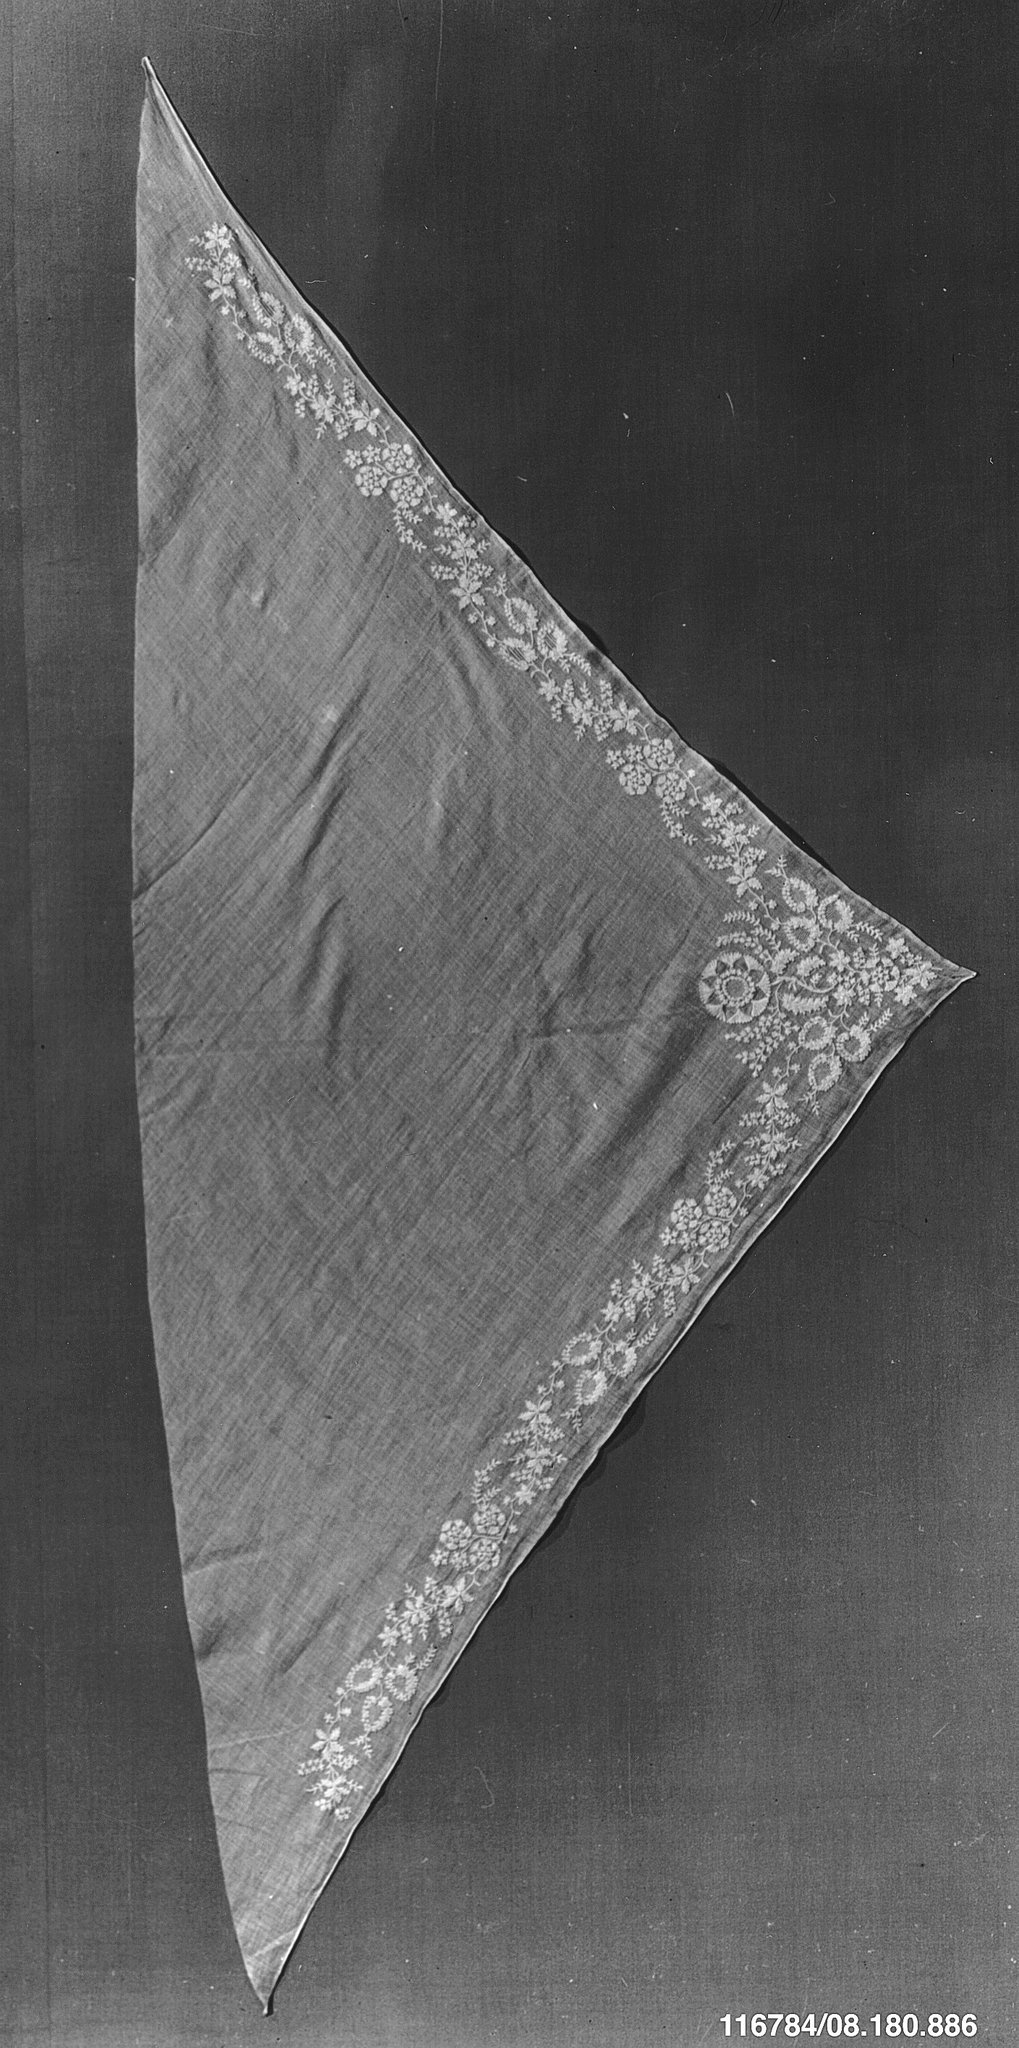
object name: kerchief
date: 1801-1833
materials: cotton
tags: flowers